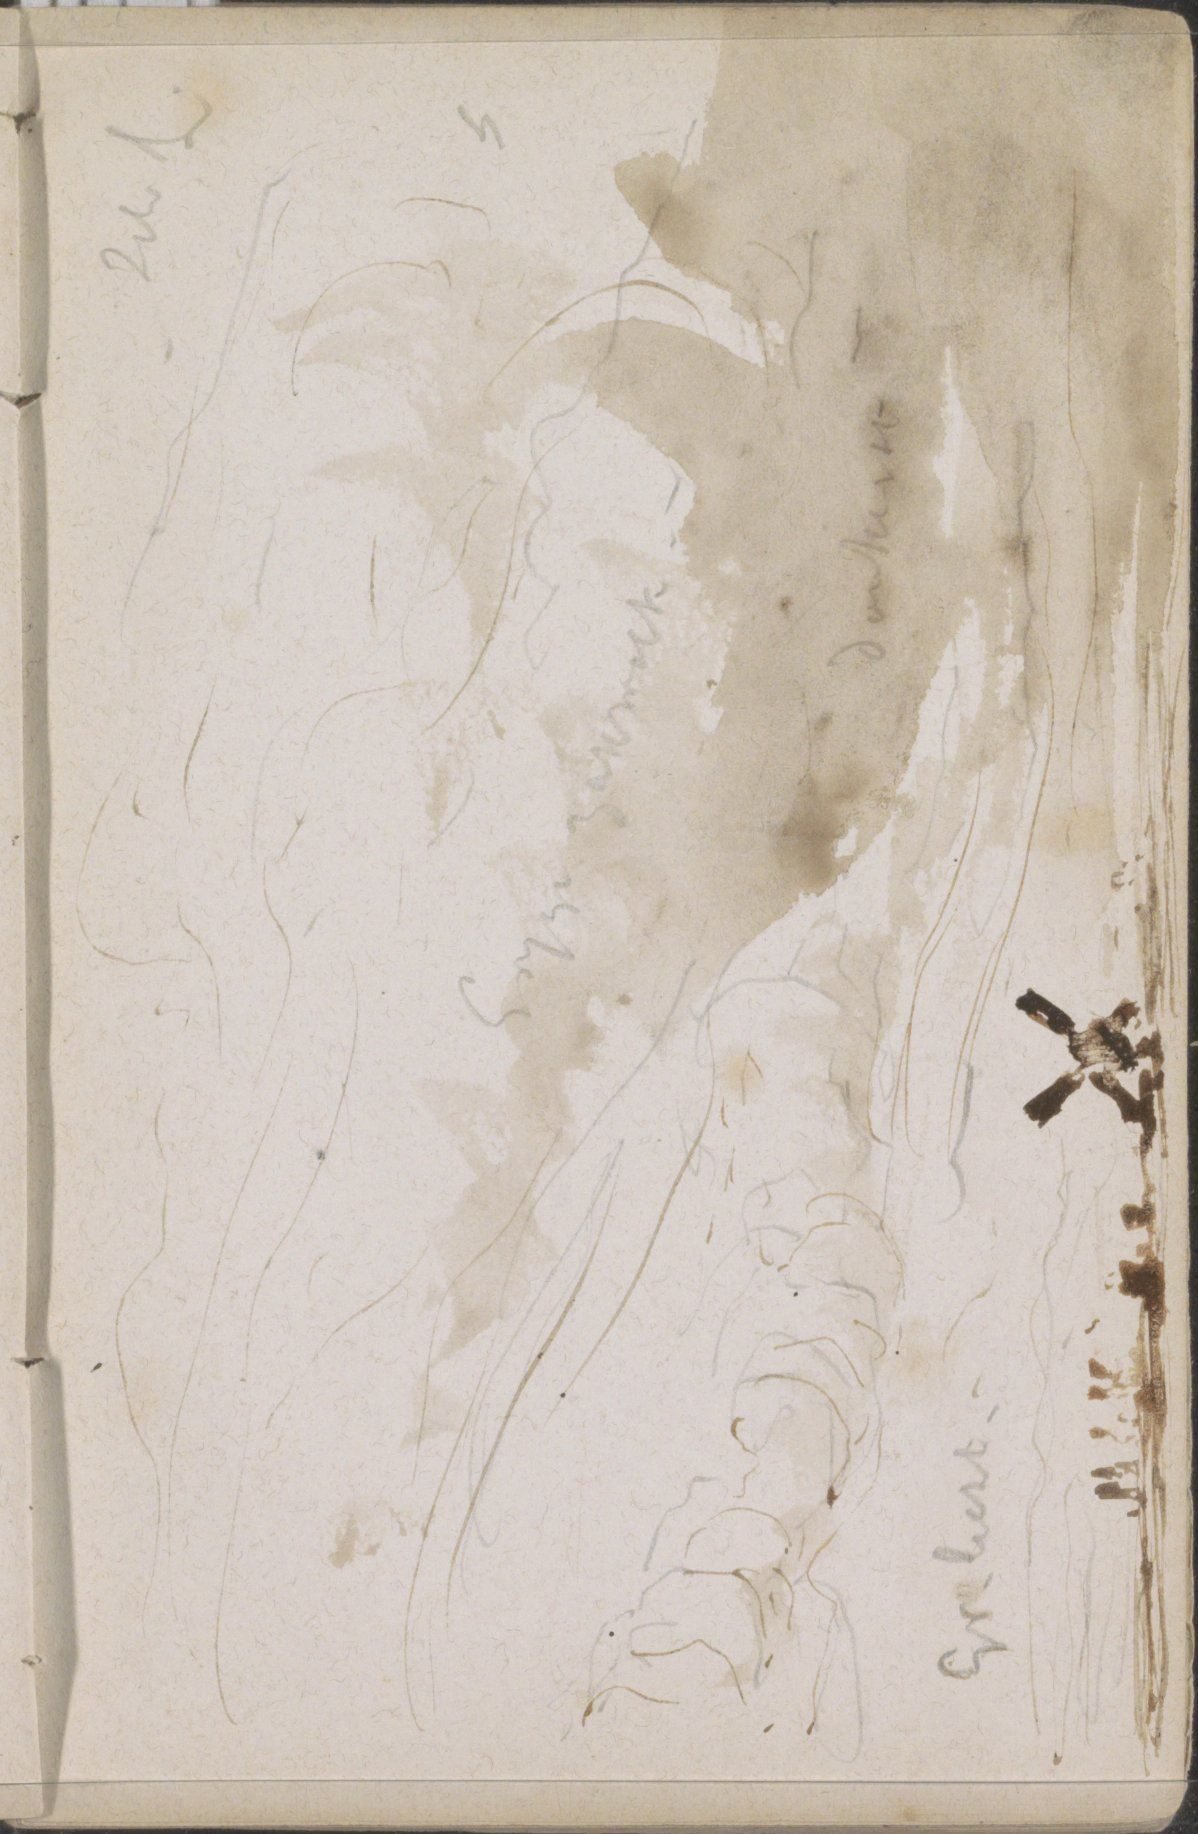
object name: sketchbook leaf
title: Wolkenlucht boven een landschap met een molen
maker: johannes tavenraat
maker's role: draughtsman, painter, print maker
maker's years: 1809-1881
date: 1862-1864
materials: ink, paper, pencil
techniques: brush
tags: clouds, windmill in landscape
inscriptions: kleurnotitie, handgeschreven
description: Blad 14 recto uit een schetsboek met 65 bladen.